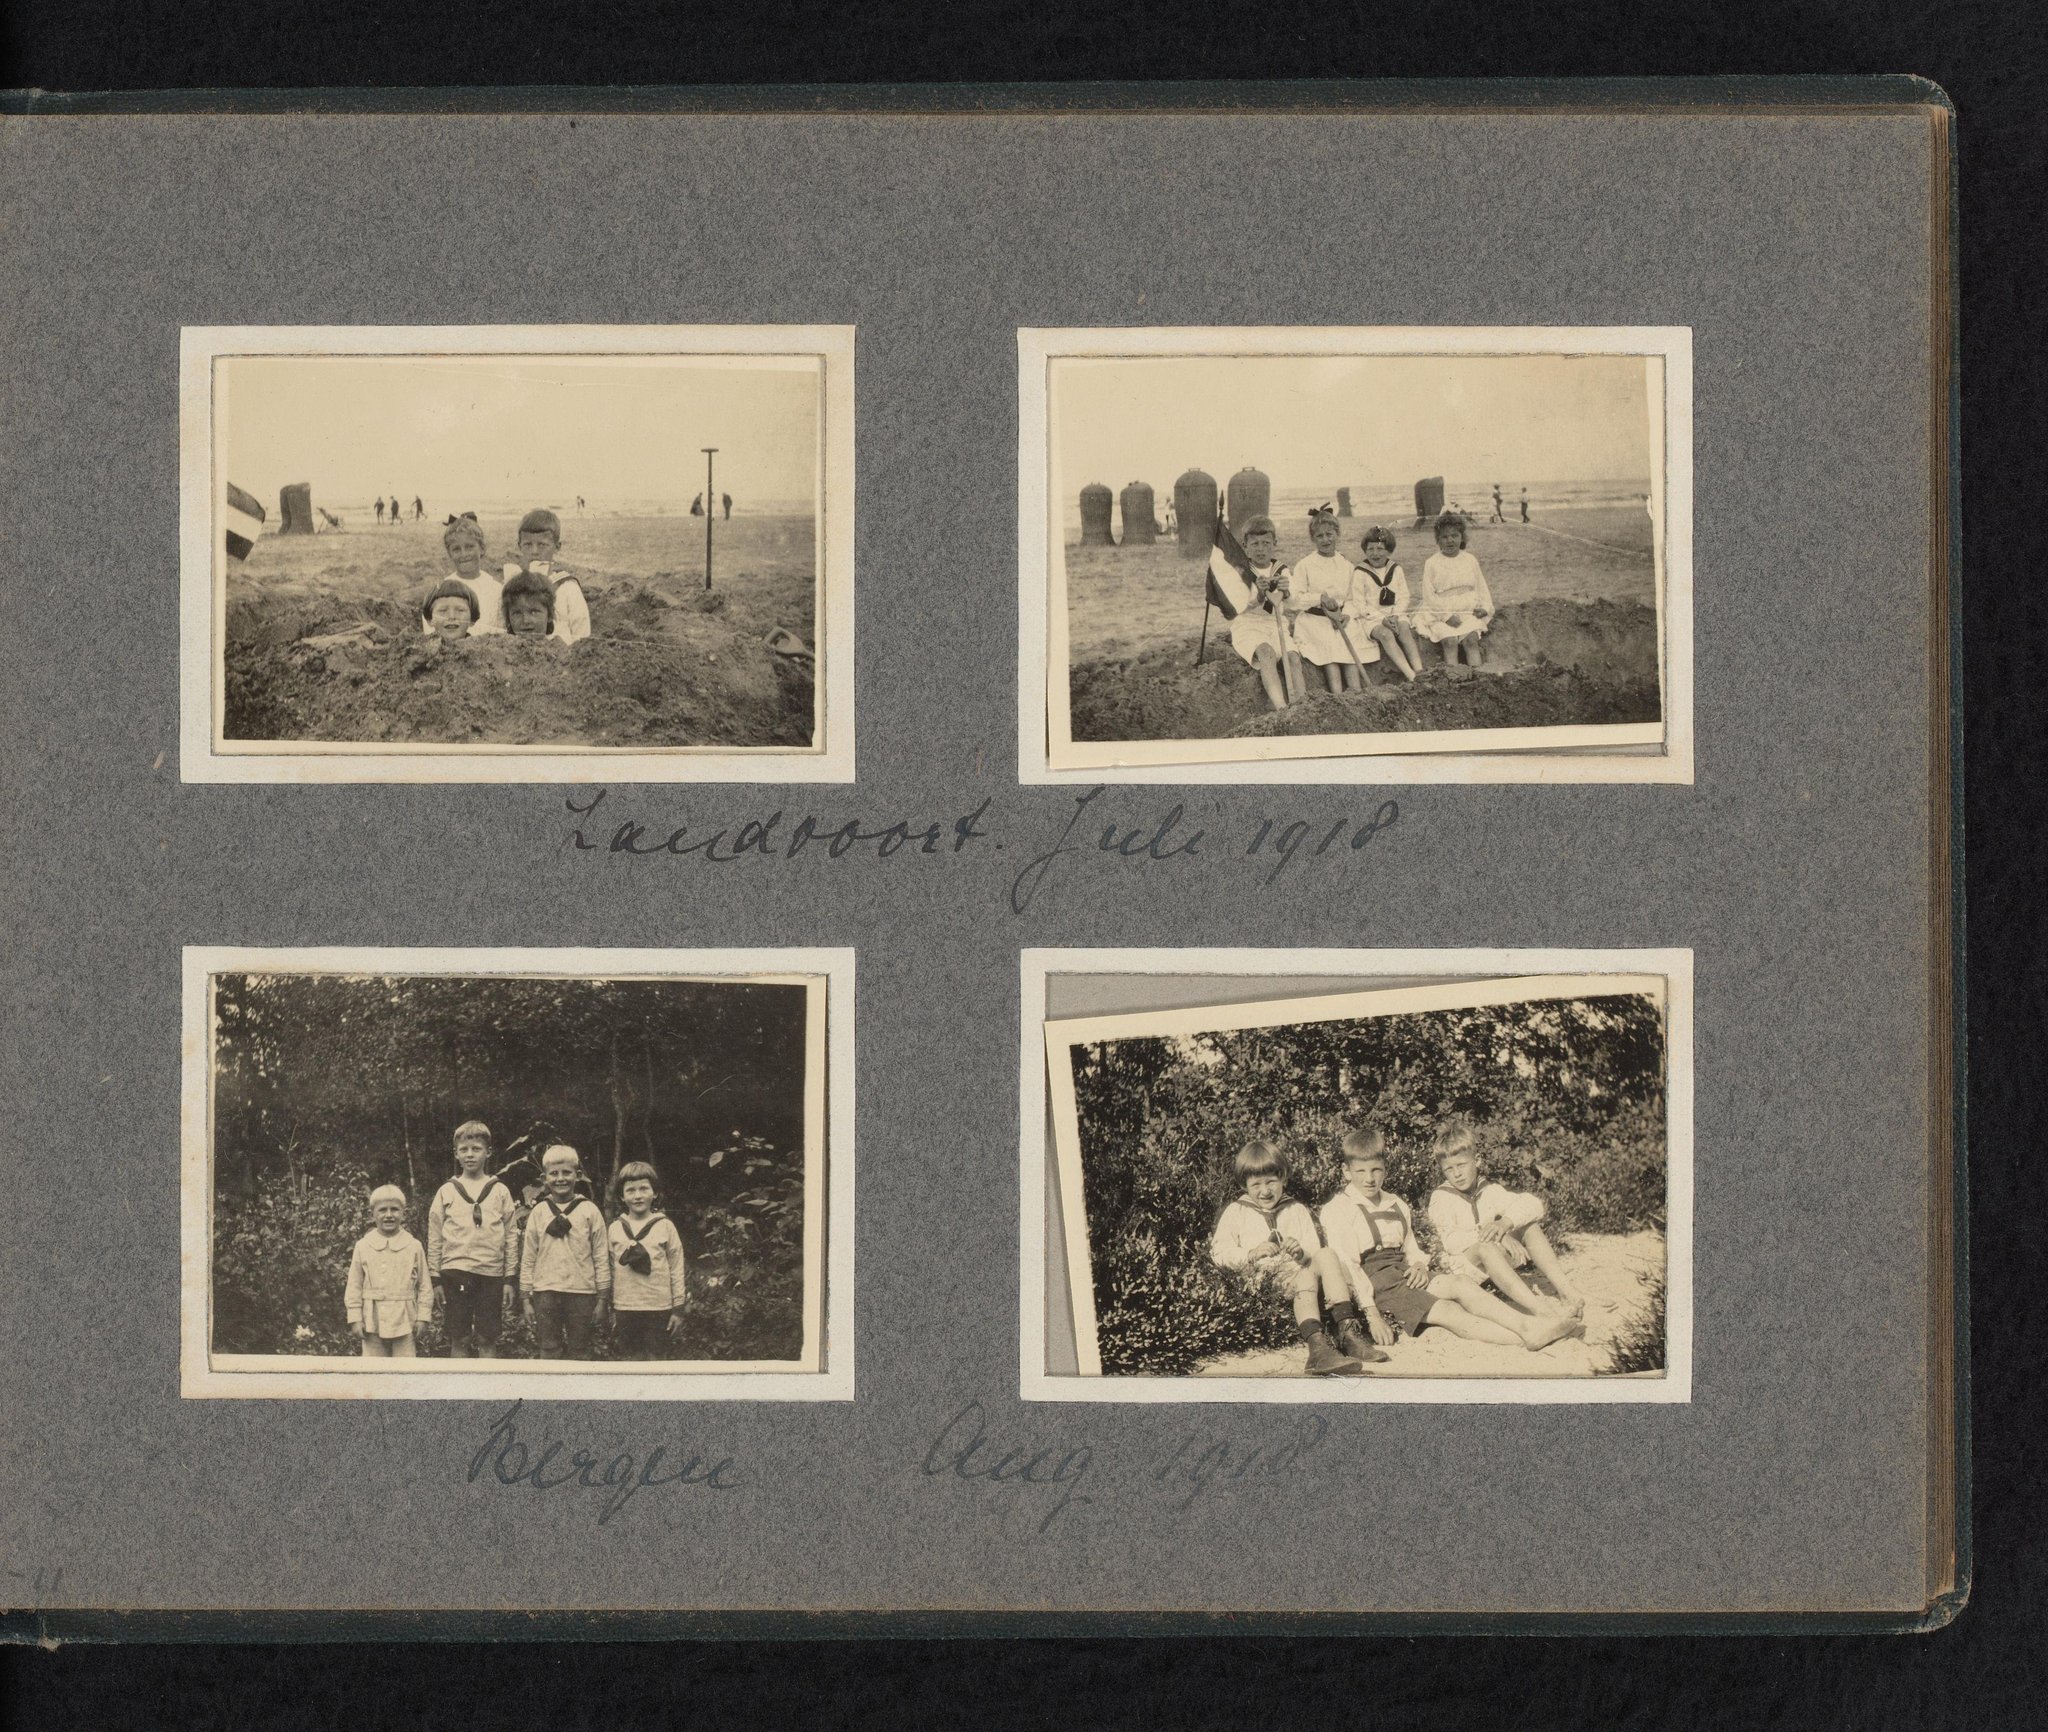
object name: photograph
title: Kinderen van de familie van den berg op het strand van Zandvoort en in Bergerac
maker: hendrik herman van den berg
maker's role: amateurfotograaf, jurist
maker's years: 1875-1944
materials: paper, cardboard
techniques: gelatin silver print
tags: beach (as place of recreation)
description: Deze foto's zijn onderdeel van een album.